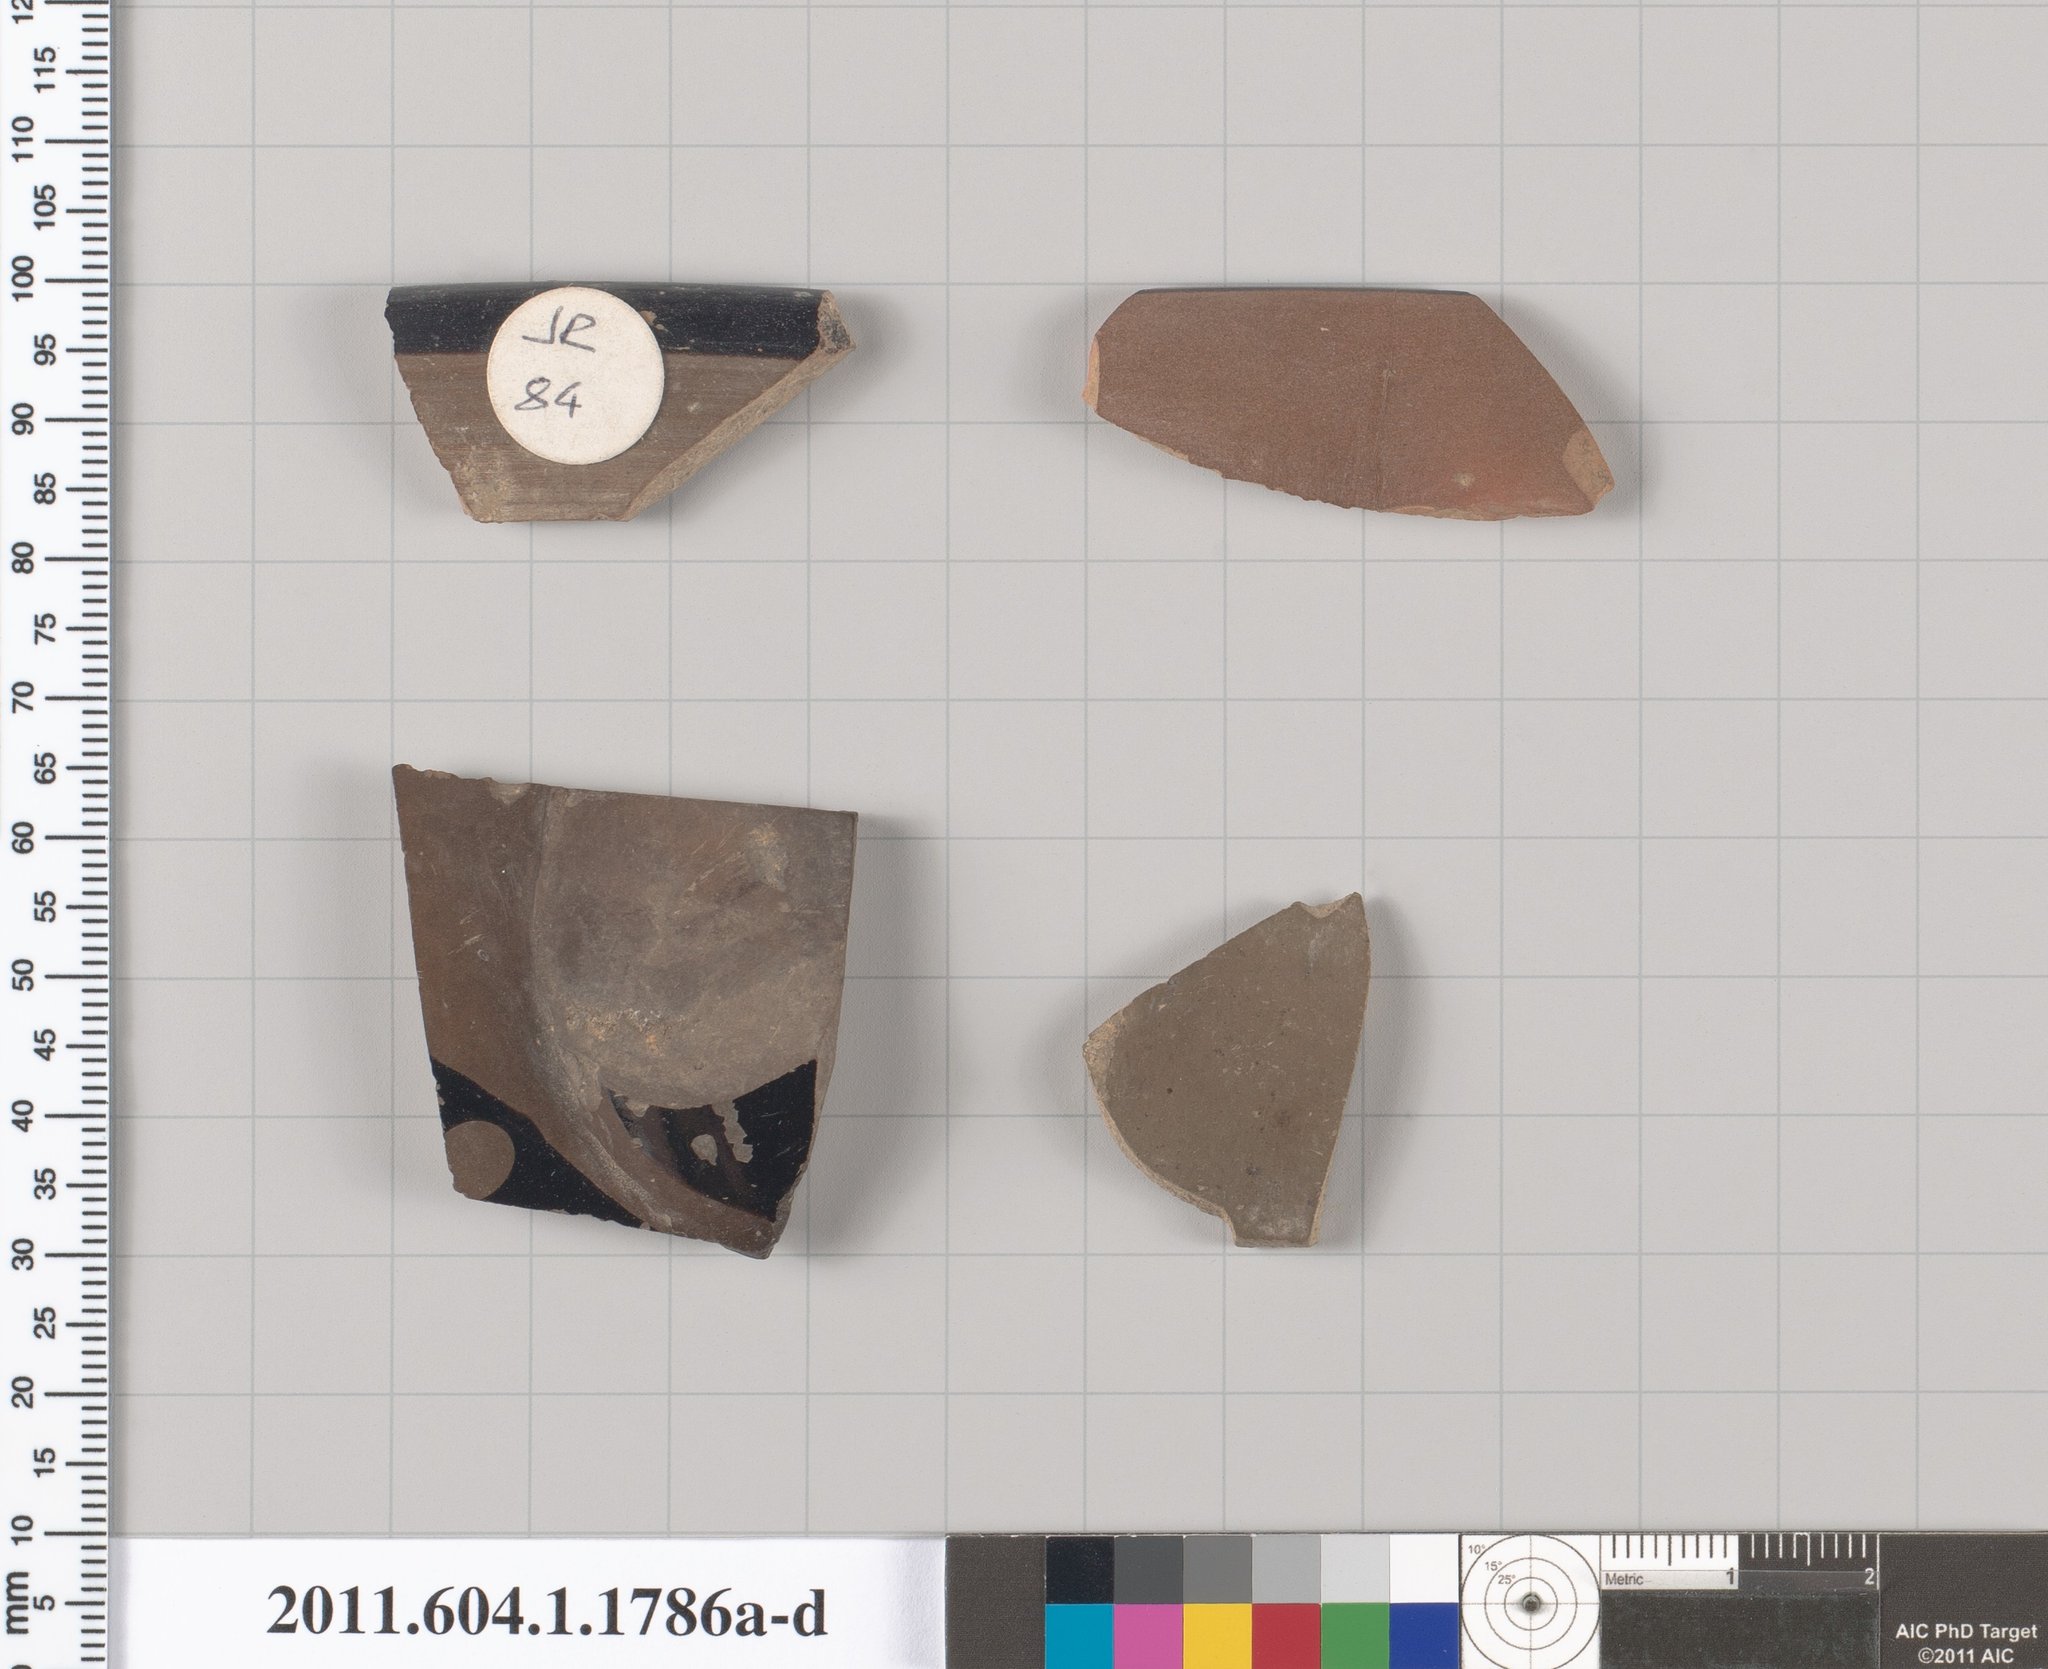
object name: kylix fragment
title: Terracotta rim fragments of kylikes(drinking cups)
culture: greek, attic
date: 500-401 BCE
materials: terracotta